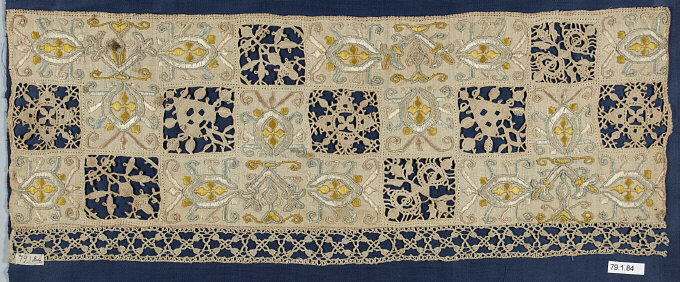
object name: band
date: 1801-1900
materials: linen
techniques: lace